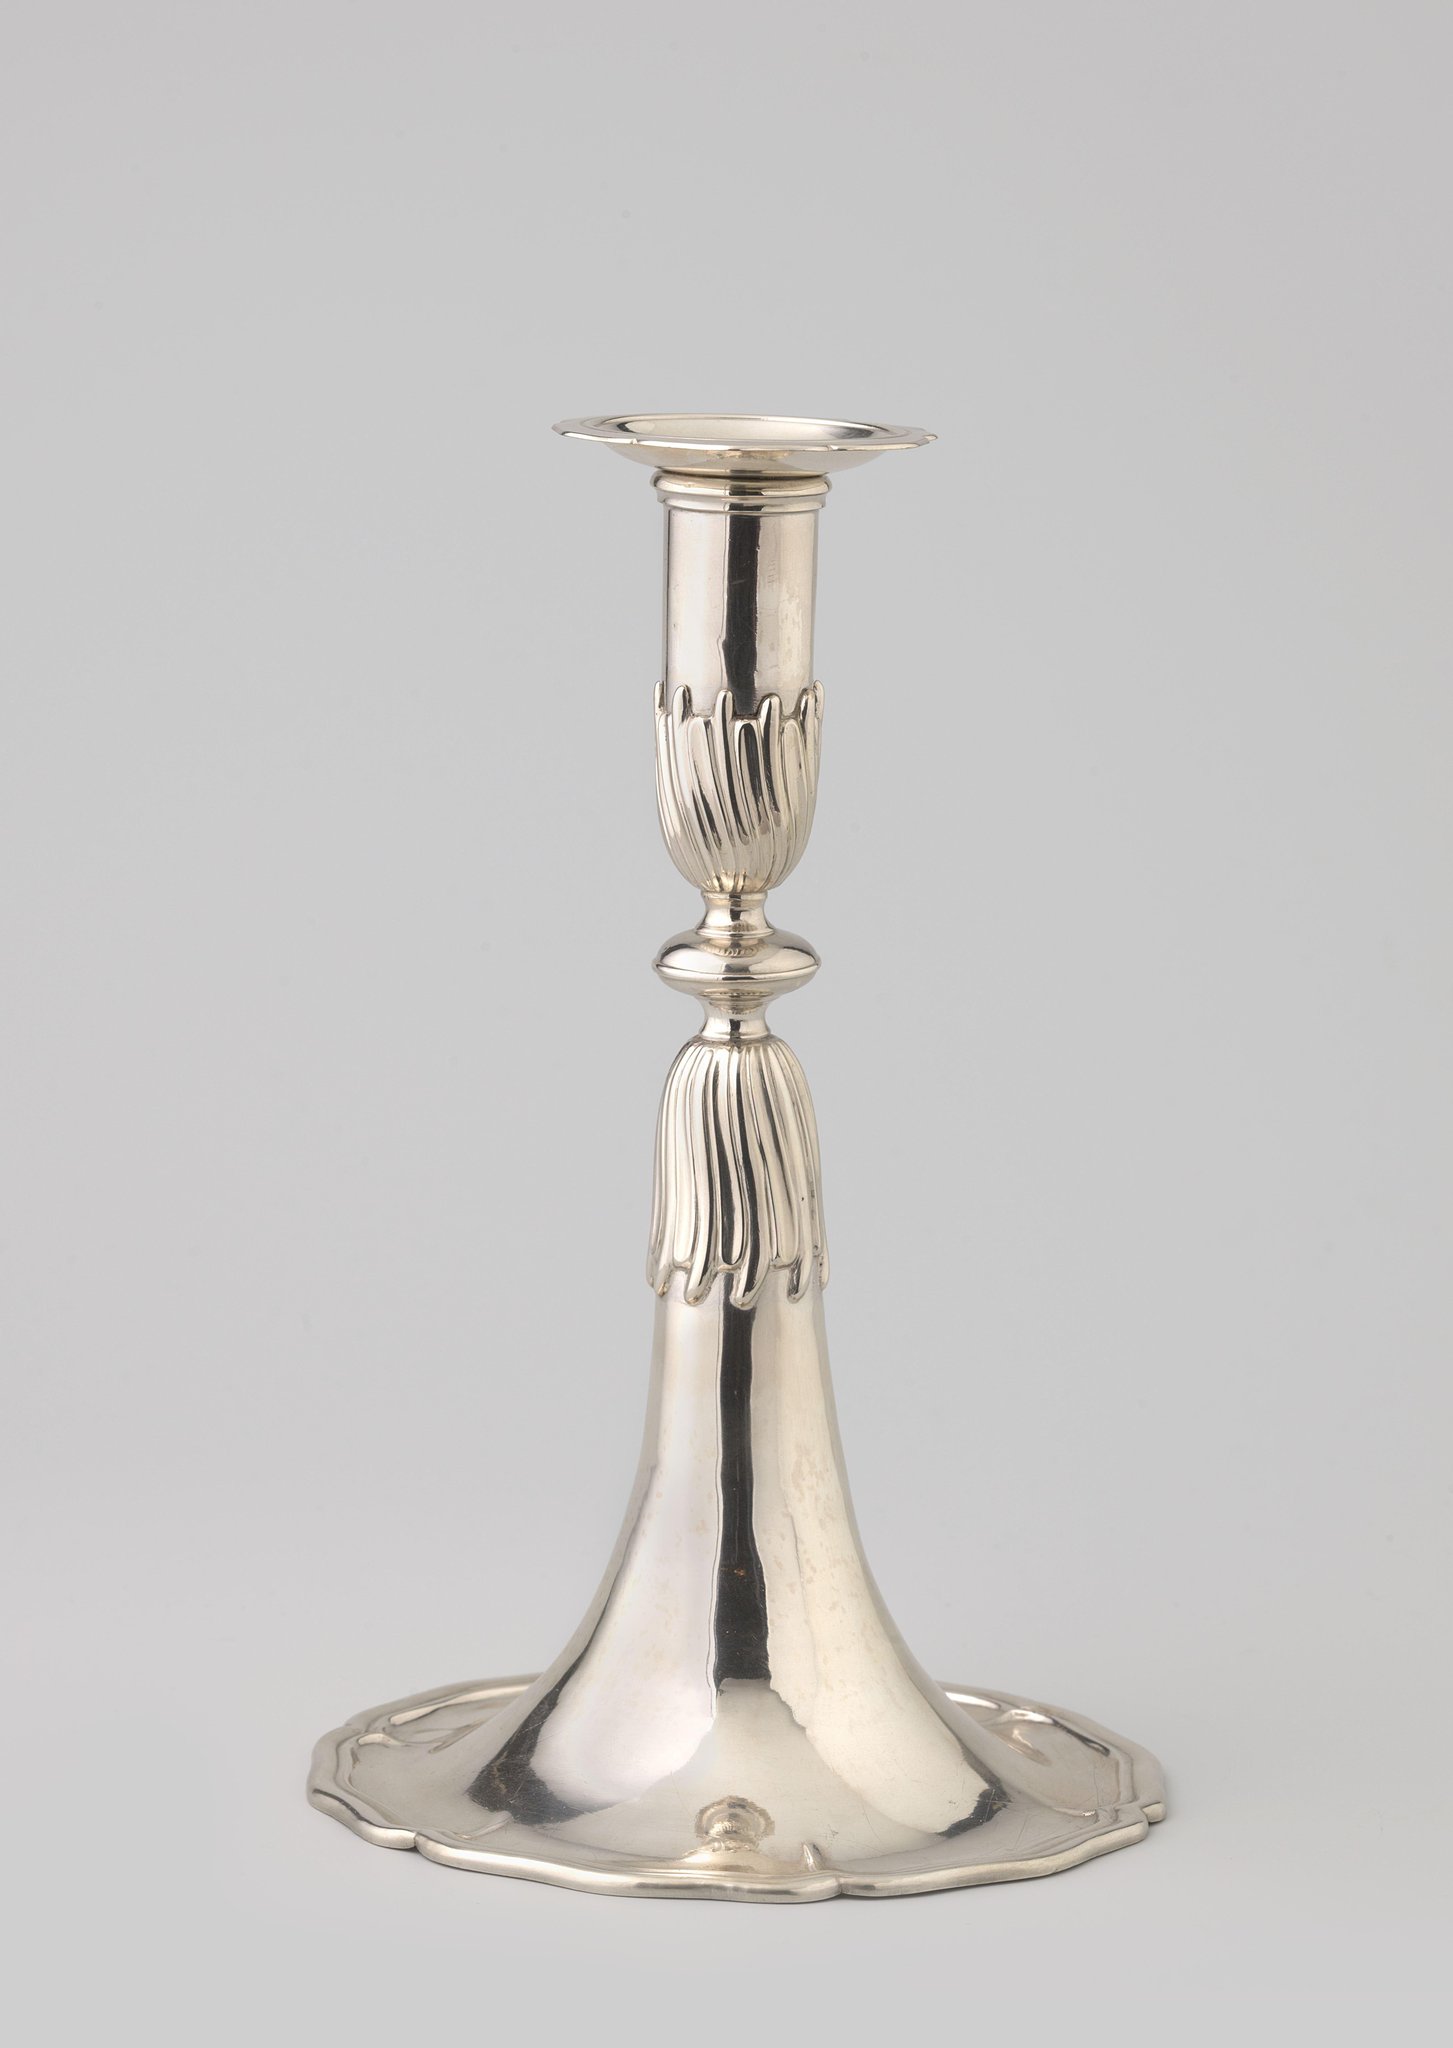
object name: candlestick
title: Kandelaar met rond, in zessen gedeeld voetblad dat geleidelijk overgaat in de stam met een schijfvormige nodus.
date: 1725-1750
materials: silver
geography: lausanne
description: Kandelaar met rond, in zessen gedeeld voetblad dat geleidelijk overgaat in de stam met een schijfvormige nodus. Gemerkt.